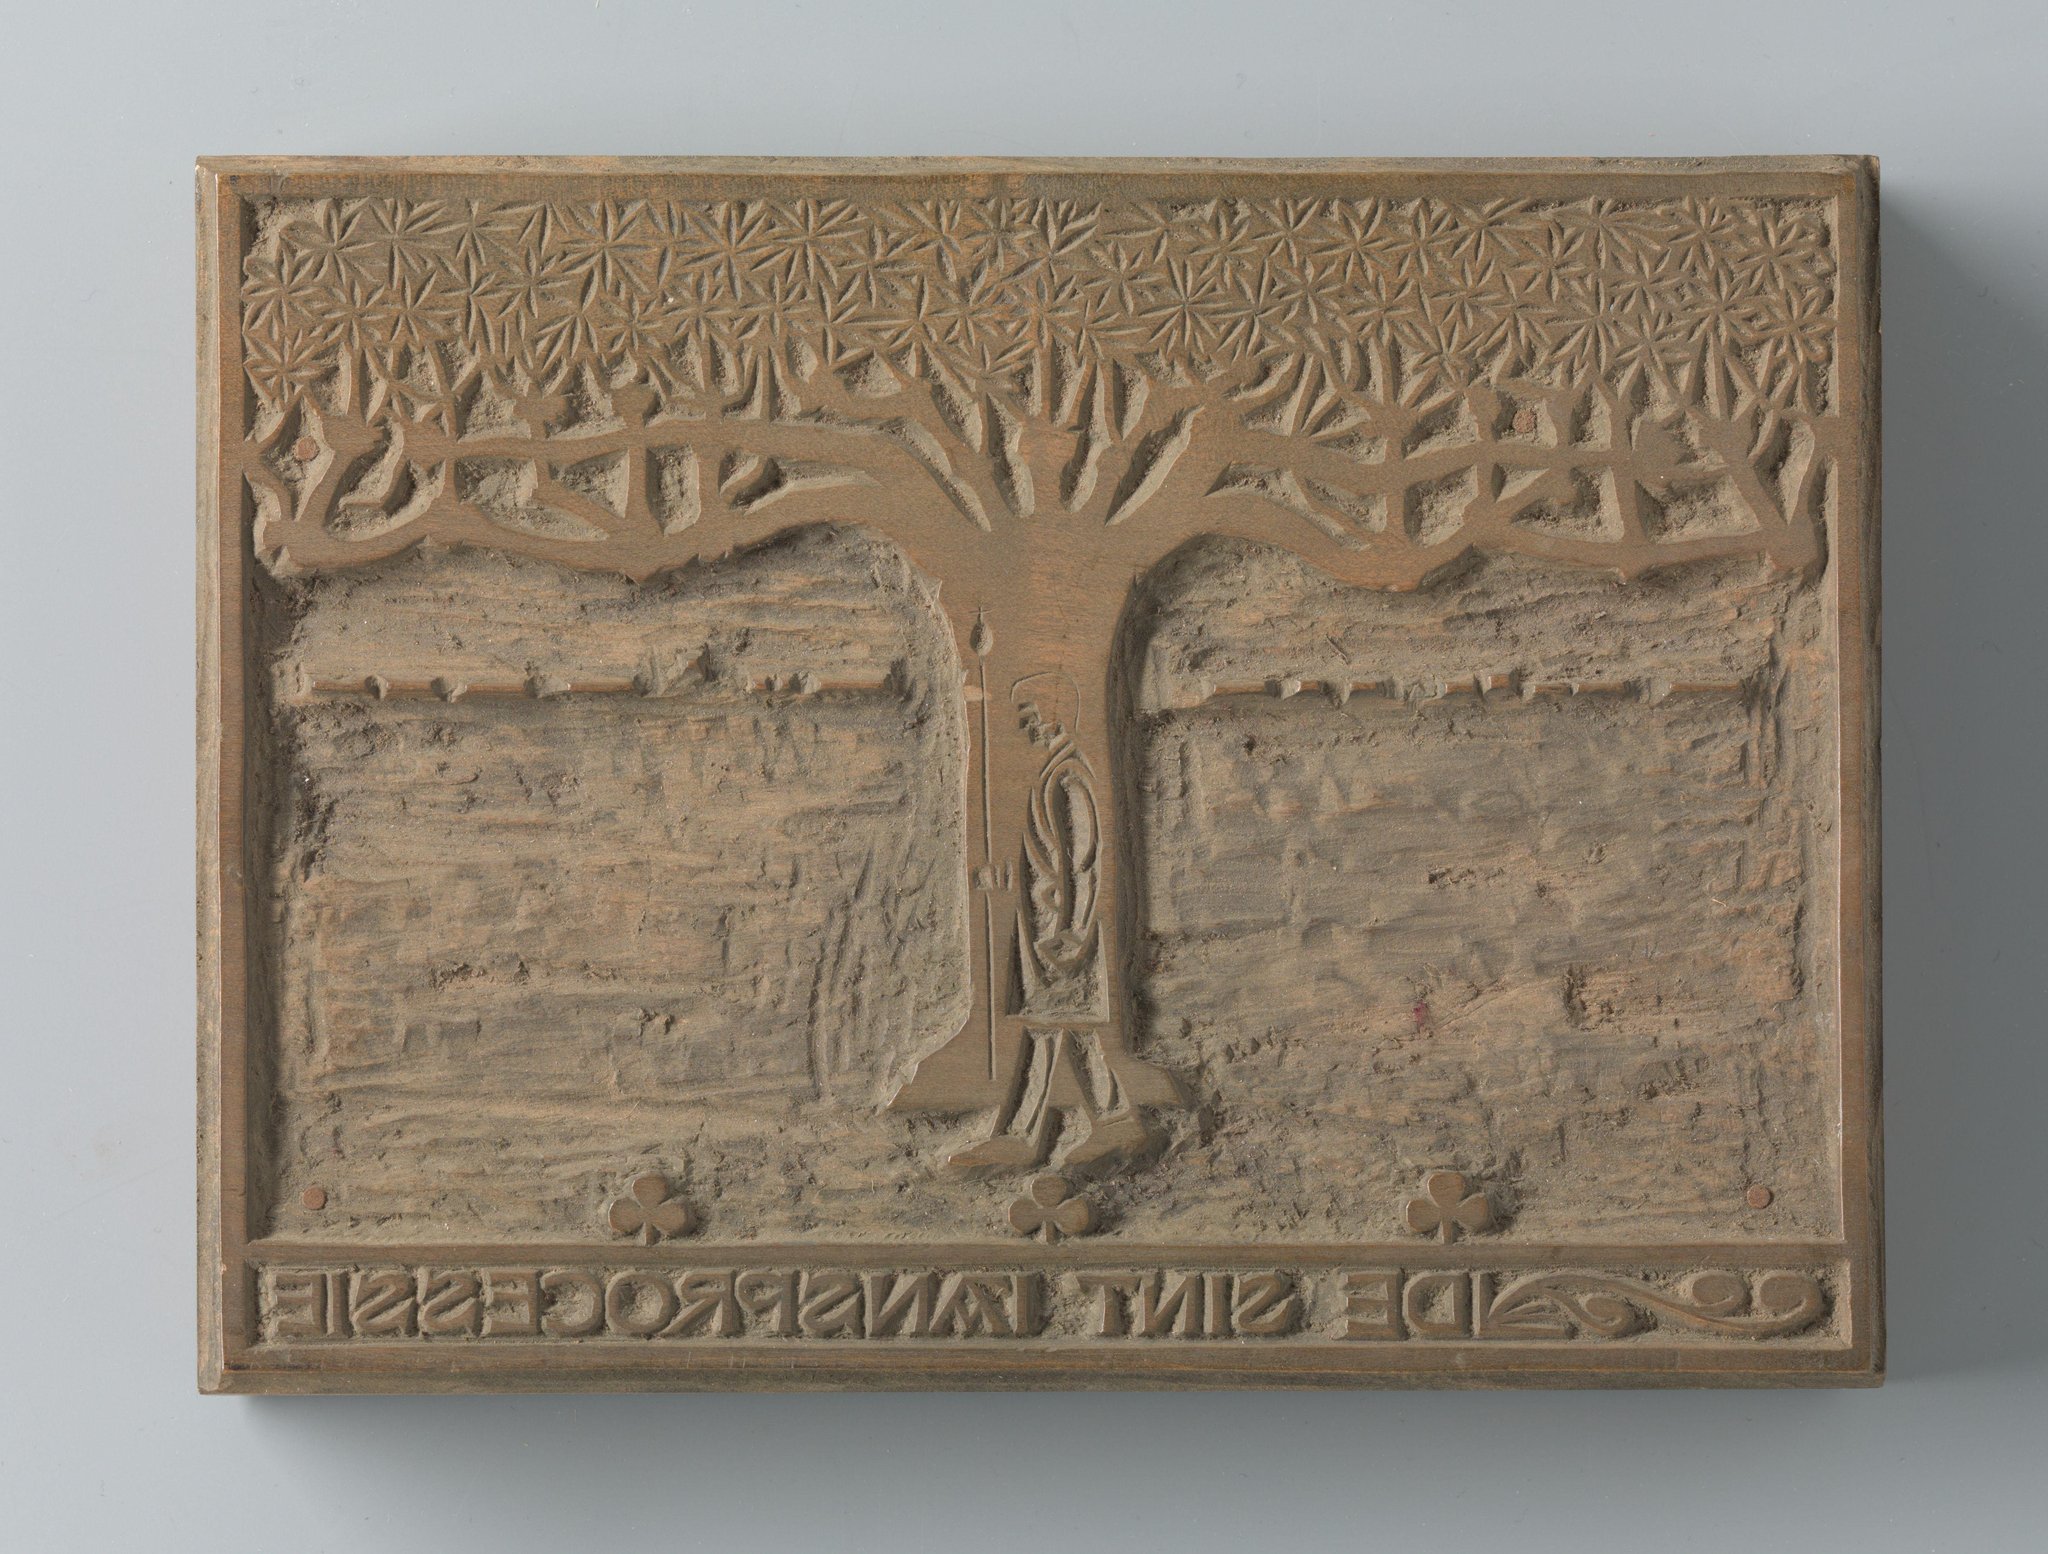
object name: wood block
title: Sint-Jansprocessie te Laren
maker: pieter hendrik van moerkerken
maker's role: print maker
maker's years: 1877-1951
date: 1898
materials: wood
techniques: woodcut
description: Zes blokken voor drie prenten in tweekleurendruk. Ze vormen samen één voorstelling.